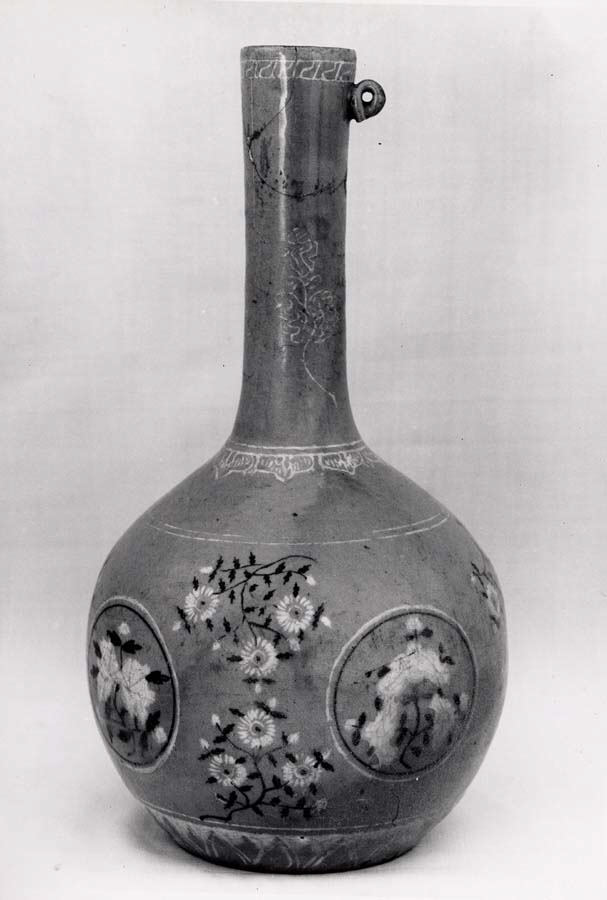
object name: vase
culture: korean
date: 1901-1933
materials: pottery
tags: flowers